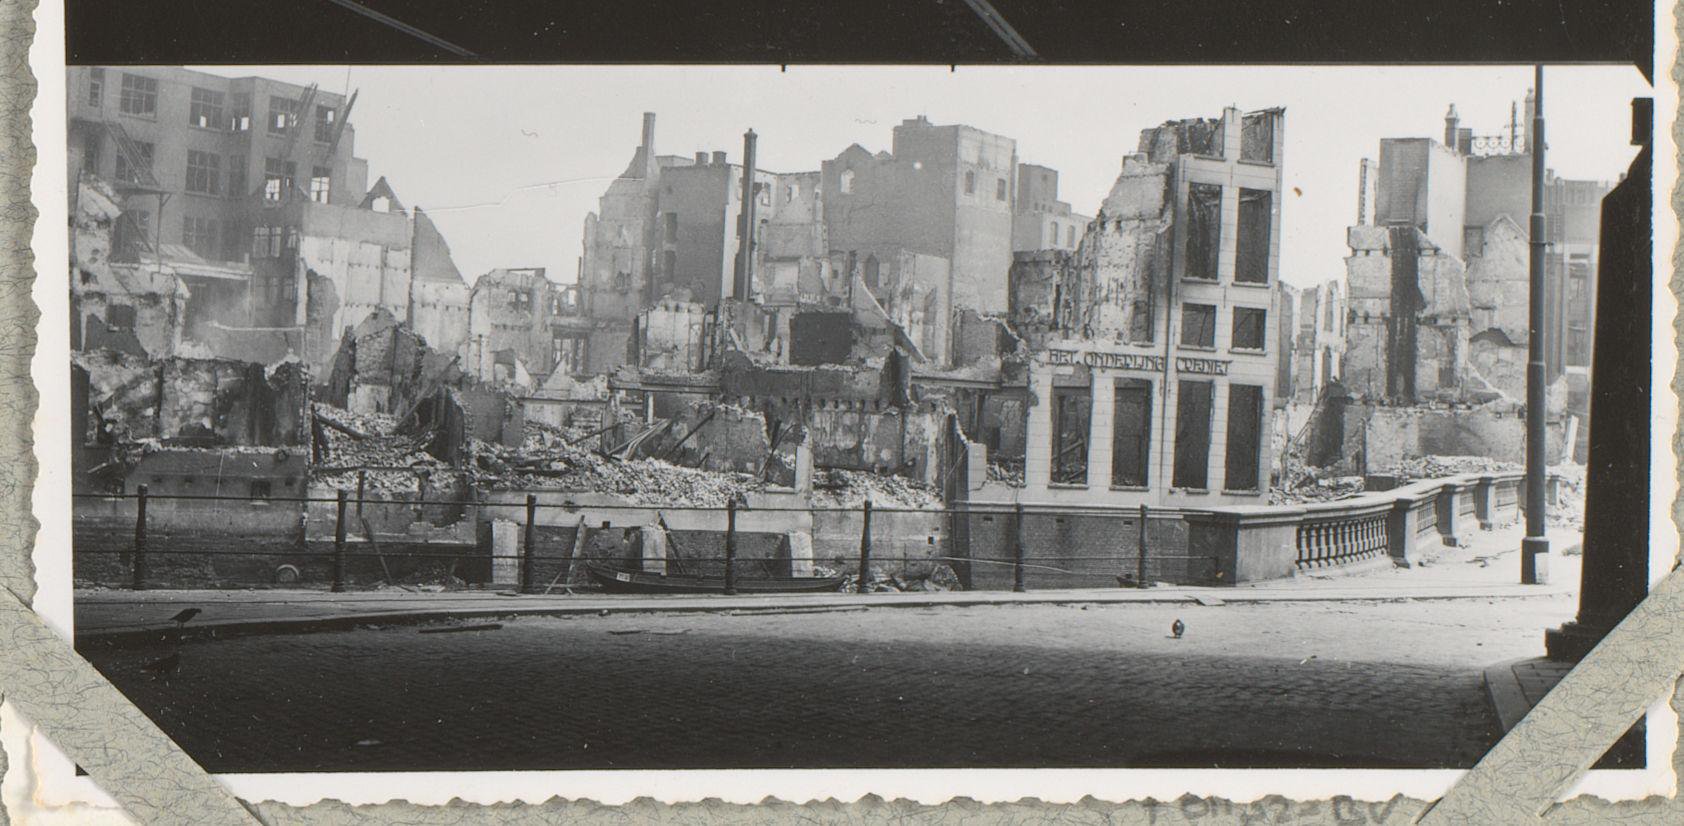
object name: photograph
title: Ruïnes van gebouwen bij de Kolk te Rotterdam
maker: j. nolte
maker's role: fotograaf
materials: photographic support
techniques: gelatin silver print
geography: rotterdam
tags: devastated, ruined place or city (~ warfare), street, ruin of a dwelling, house, castle, etc., rotterdam, rotterdam blitz